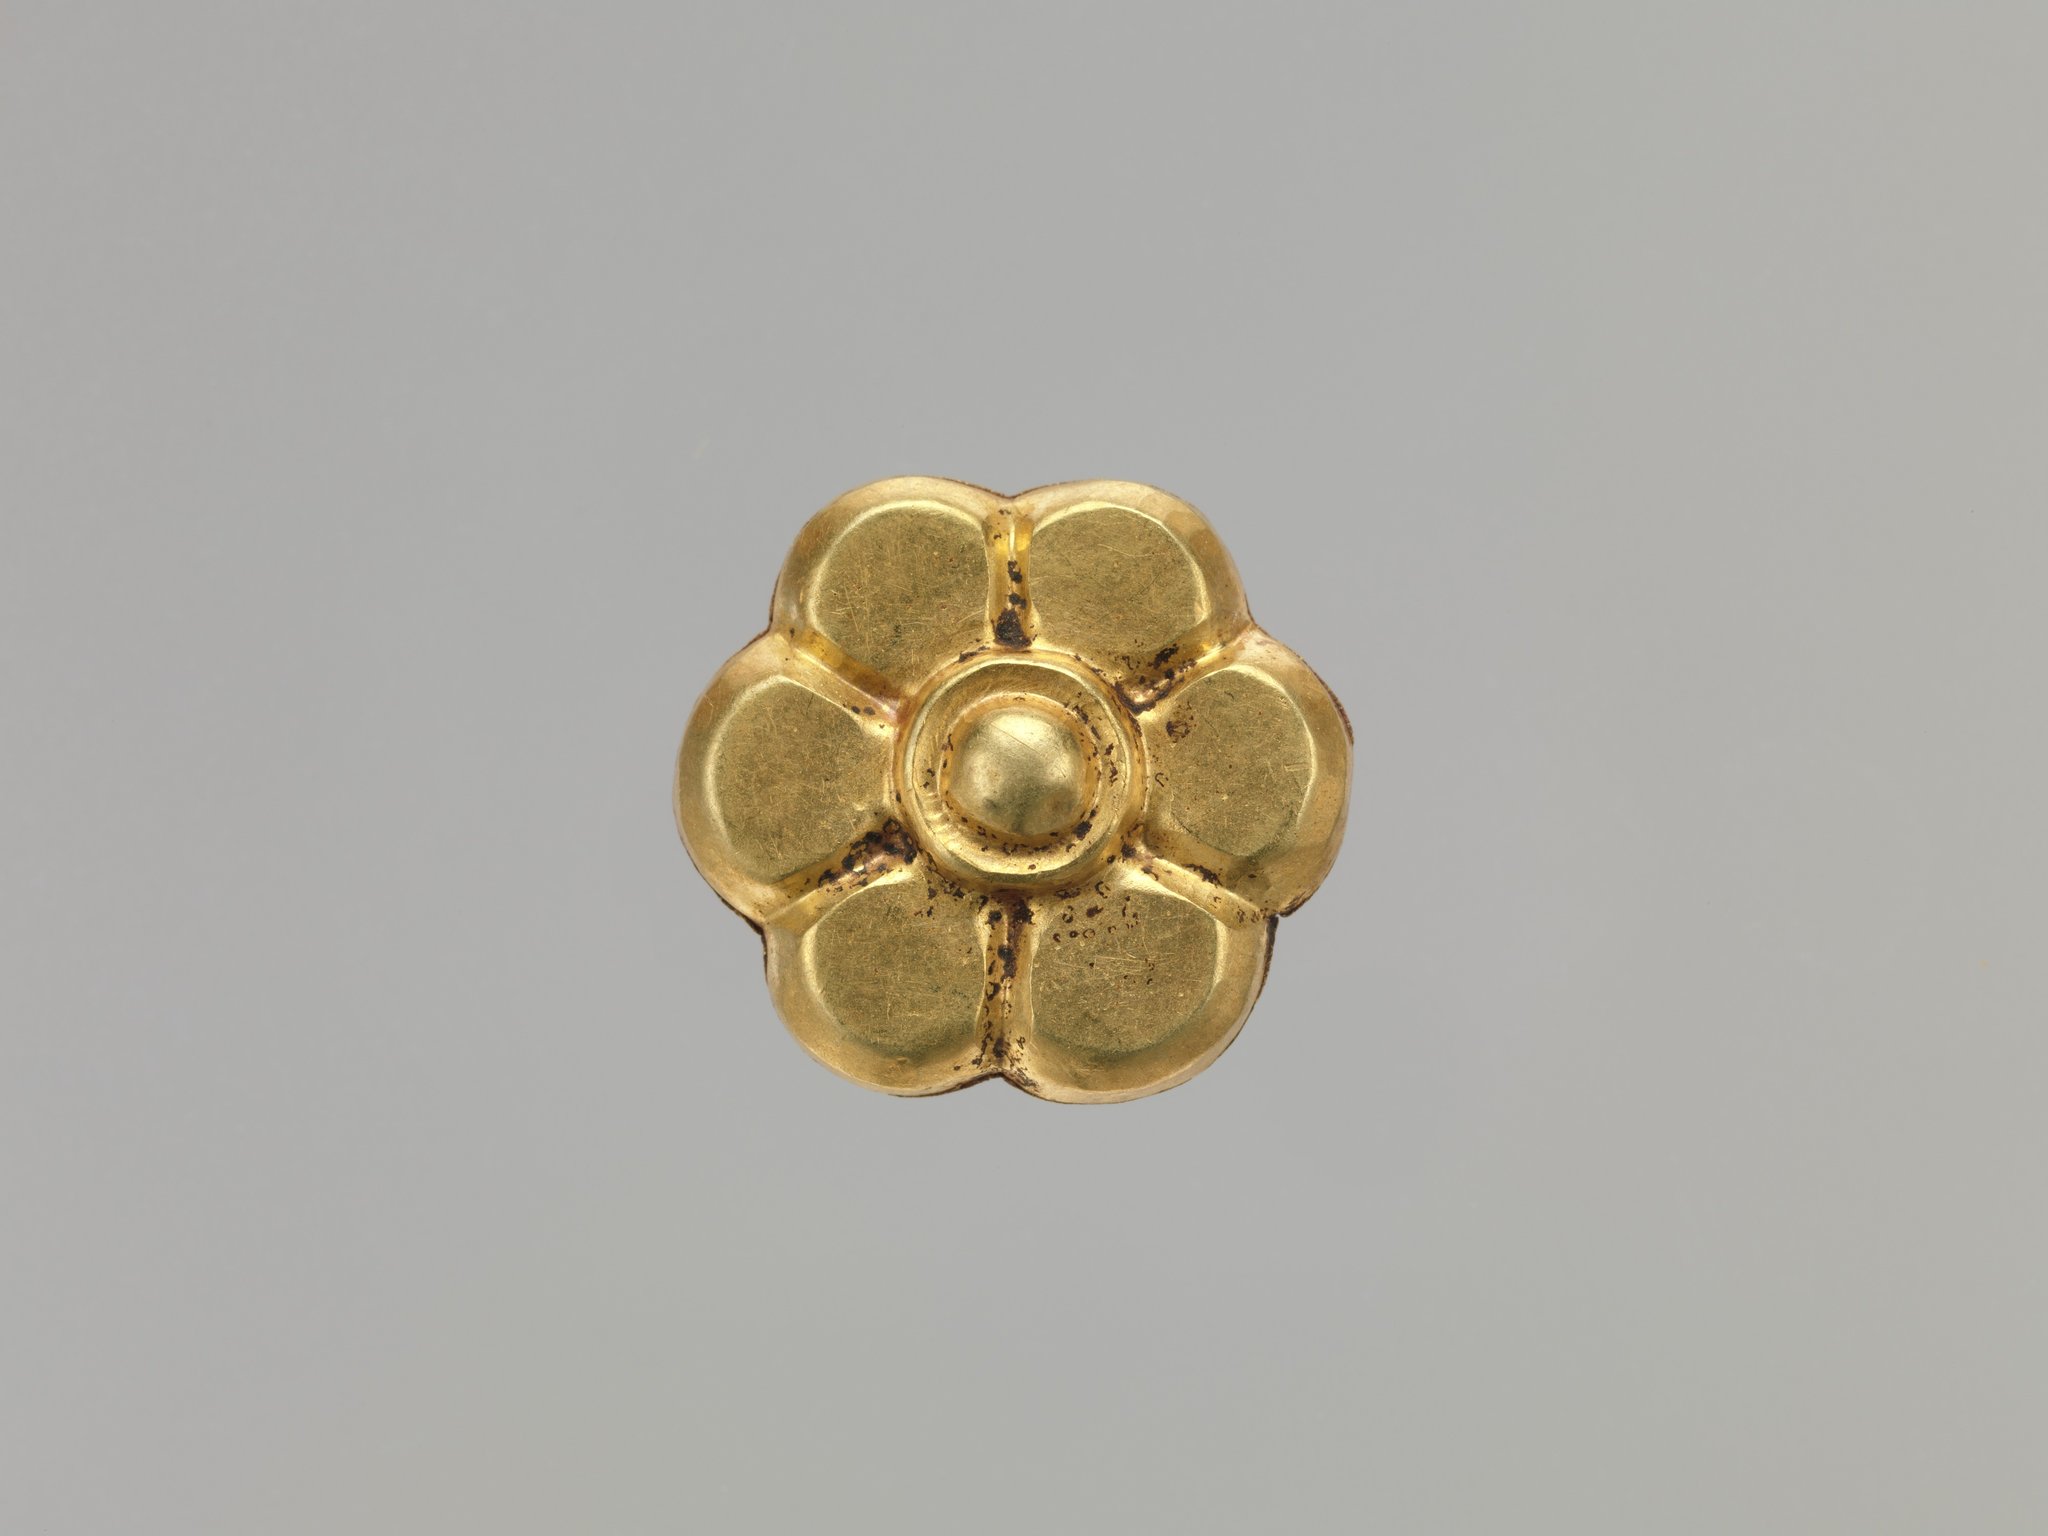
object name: attachment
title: Flower-Shaped Plaque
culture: chinese or central asian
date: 601-900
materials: gold